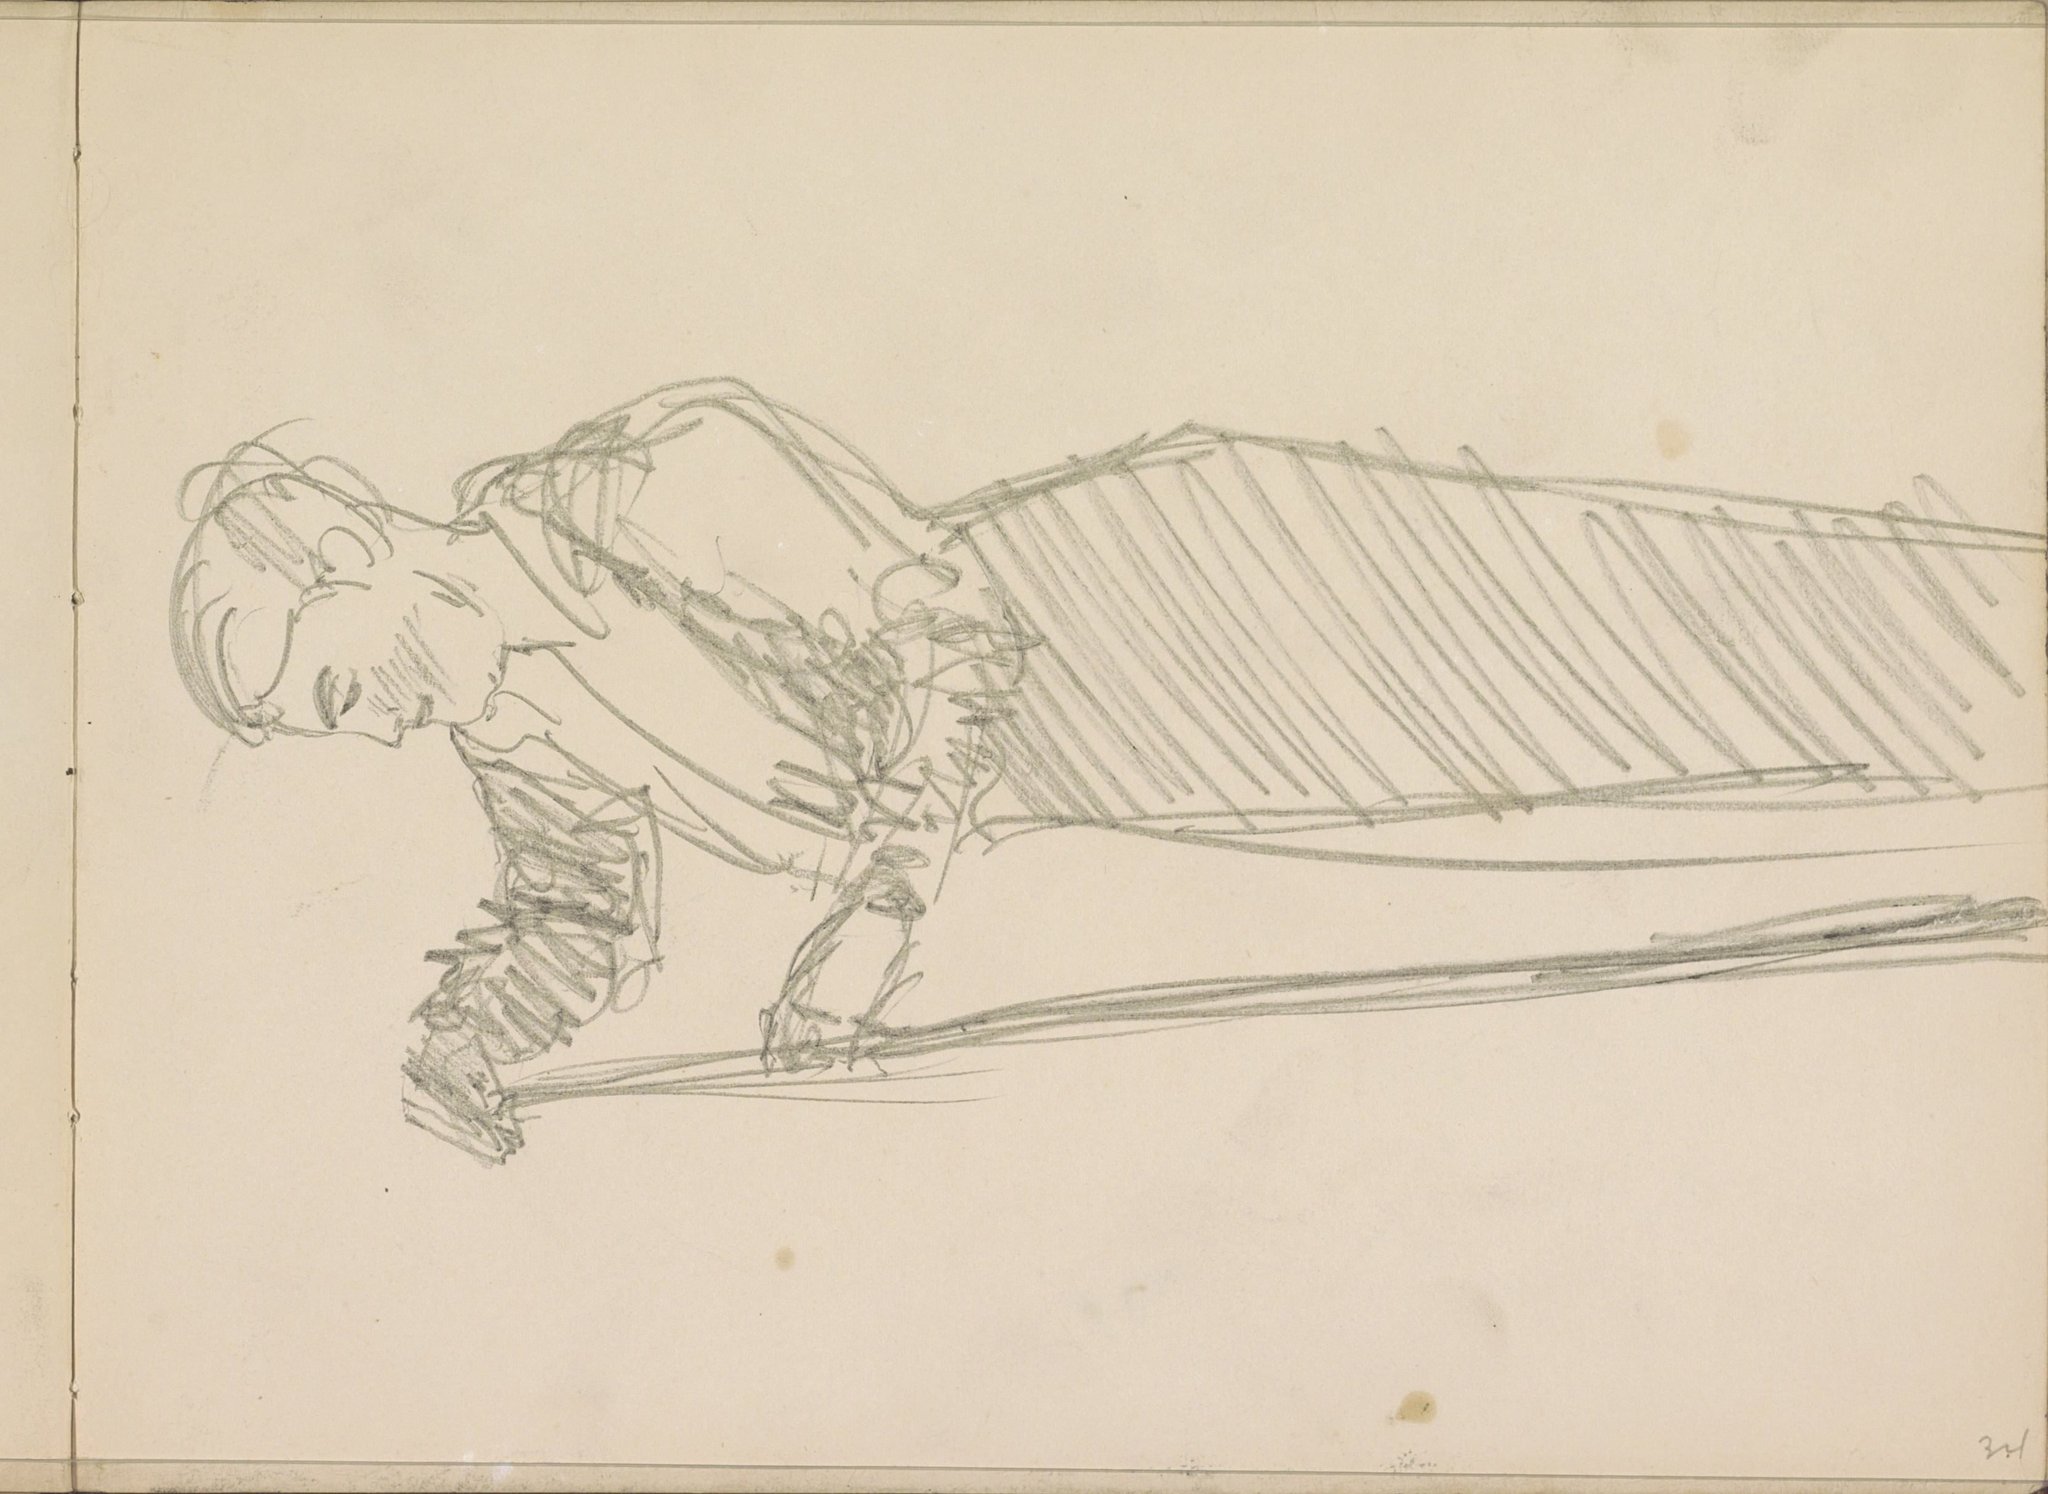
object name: sketchbook leaf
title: Vrouw die een keu krijt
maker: isaac israels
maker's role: draughtsman, painter, print maker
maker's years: 1865-1934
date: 1890-1920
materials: paper, pencil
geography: the hague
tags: adult woman, billiards (+ equipment, outfit (sports, games, etc.))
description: Blad 34 recto uit schetsboek X met 43 bladen.